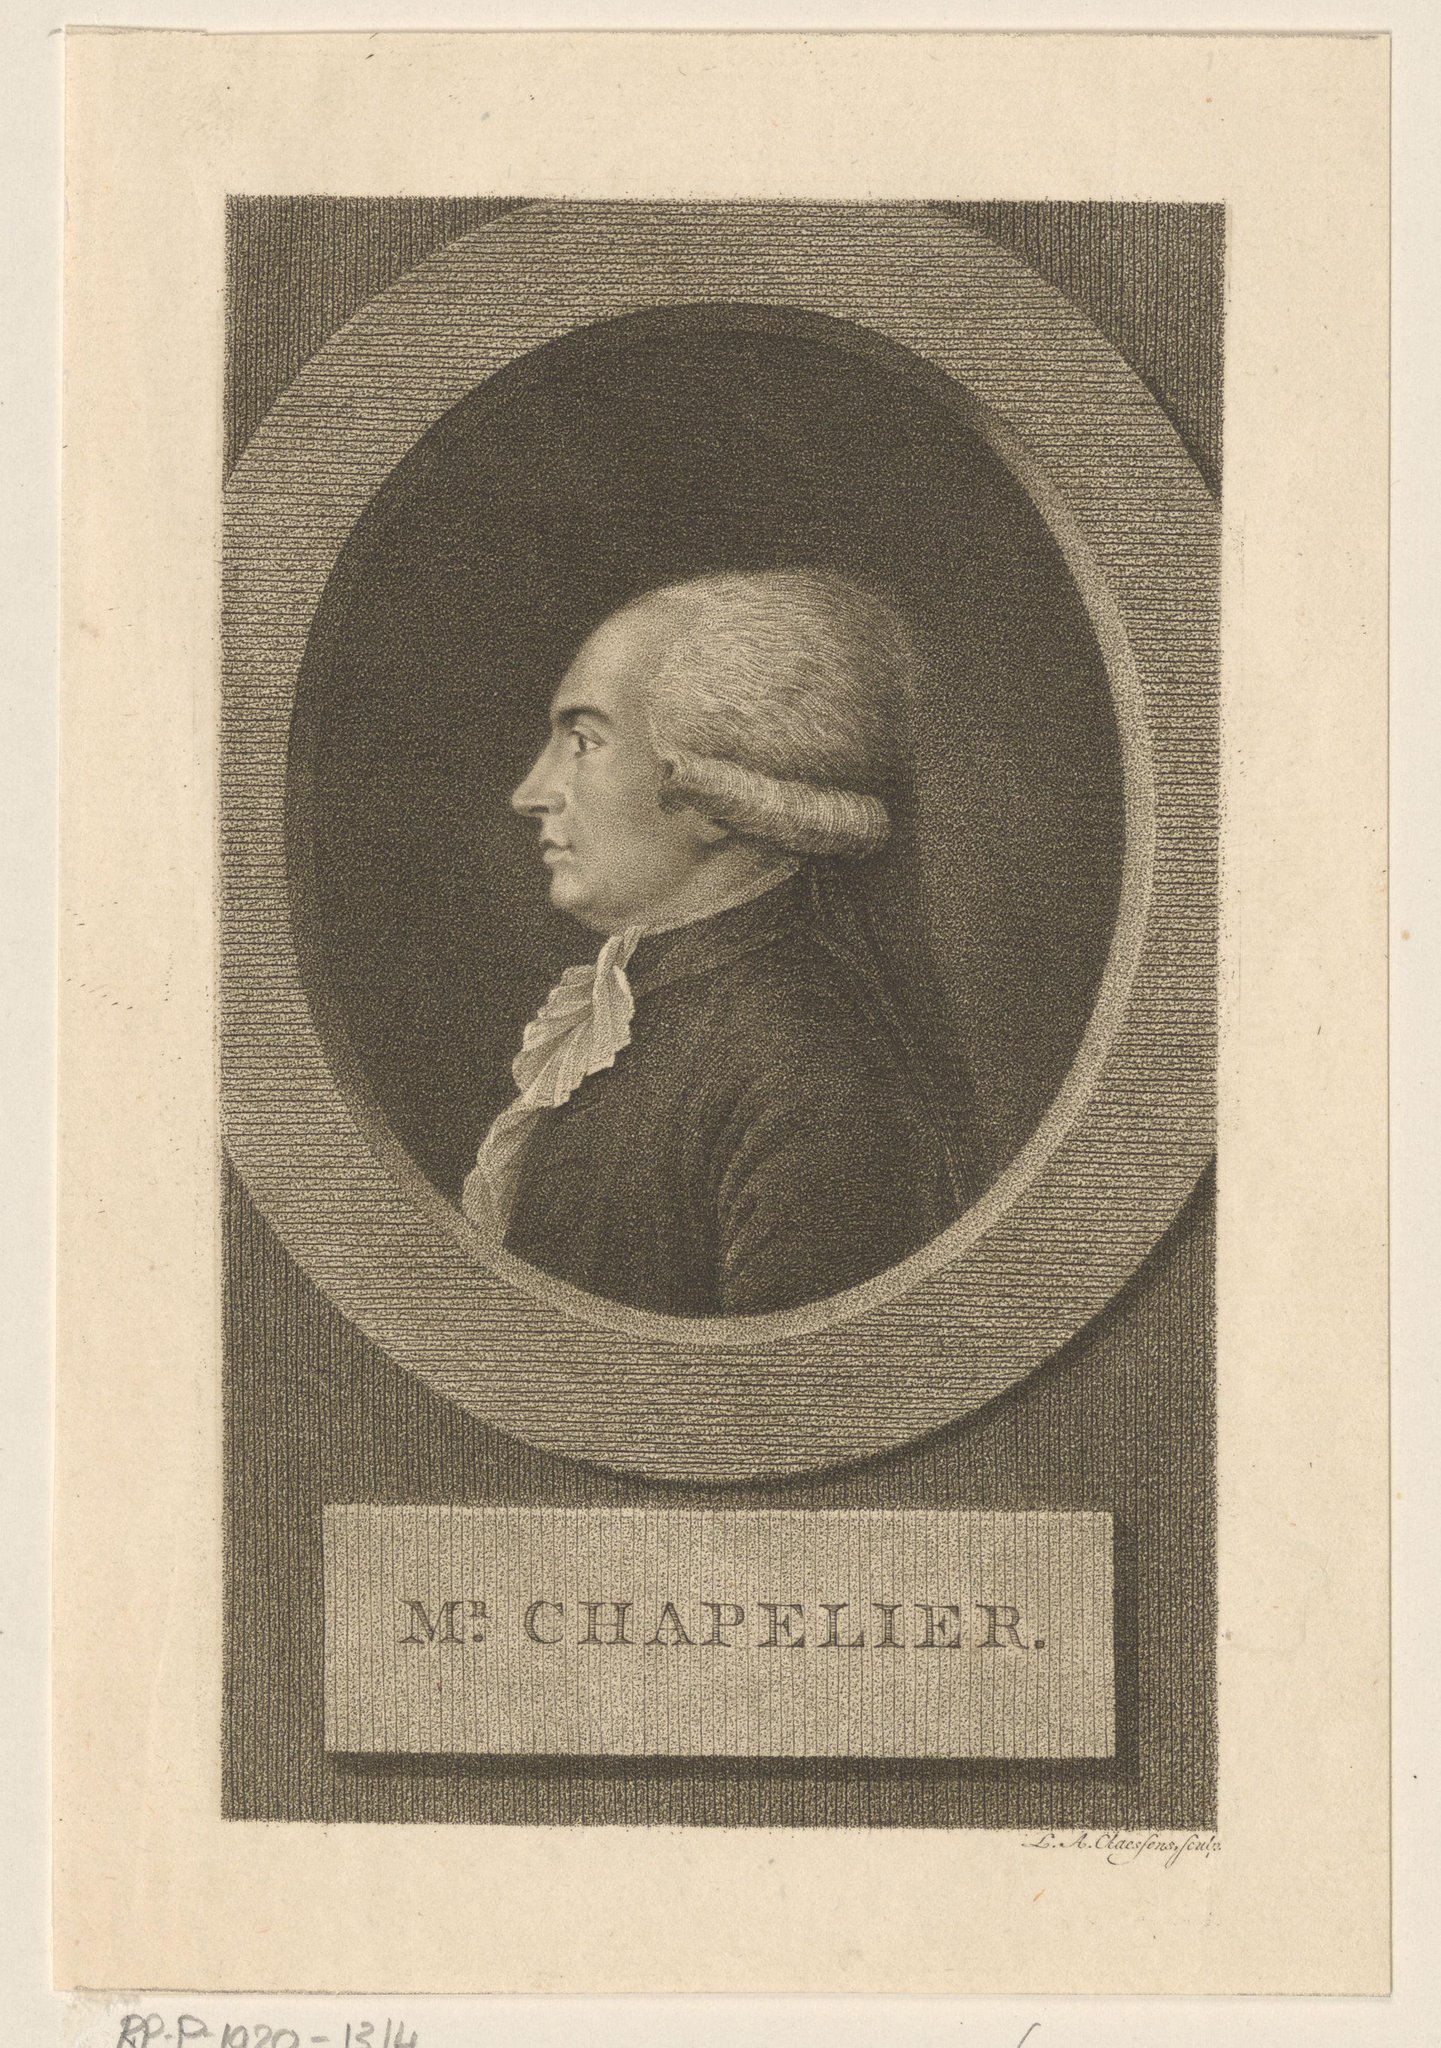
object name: print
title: Portret van Isaac René Guy le Chapelier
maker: lambertus antonius claessens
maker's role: draughtsman, print maker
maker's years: 1763-1834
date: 1784-1834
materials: paper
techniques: engraving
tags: politician, historical persons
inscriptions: collector's mark: Lugt 2282